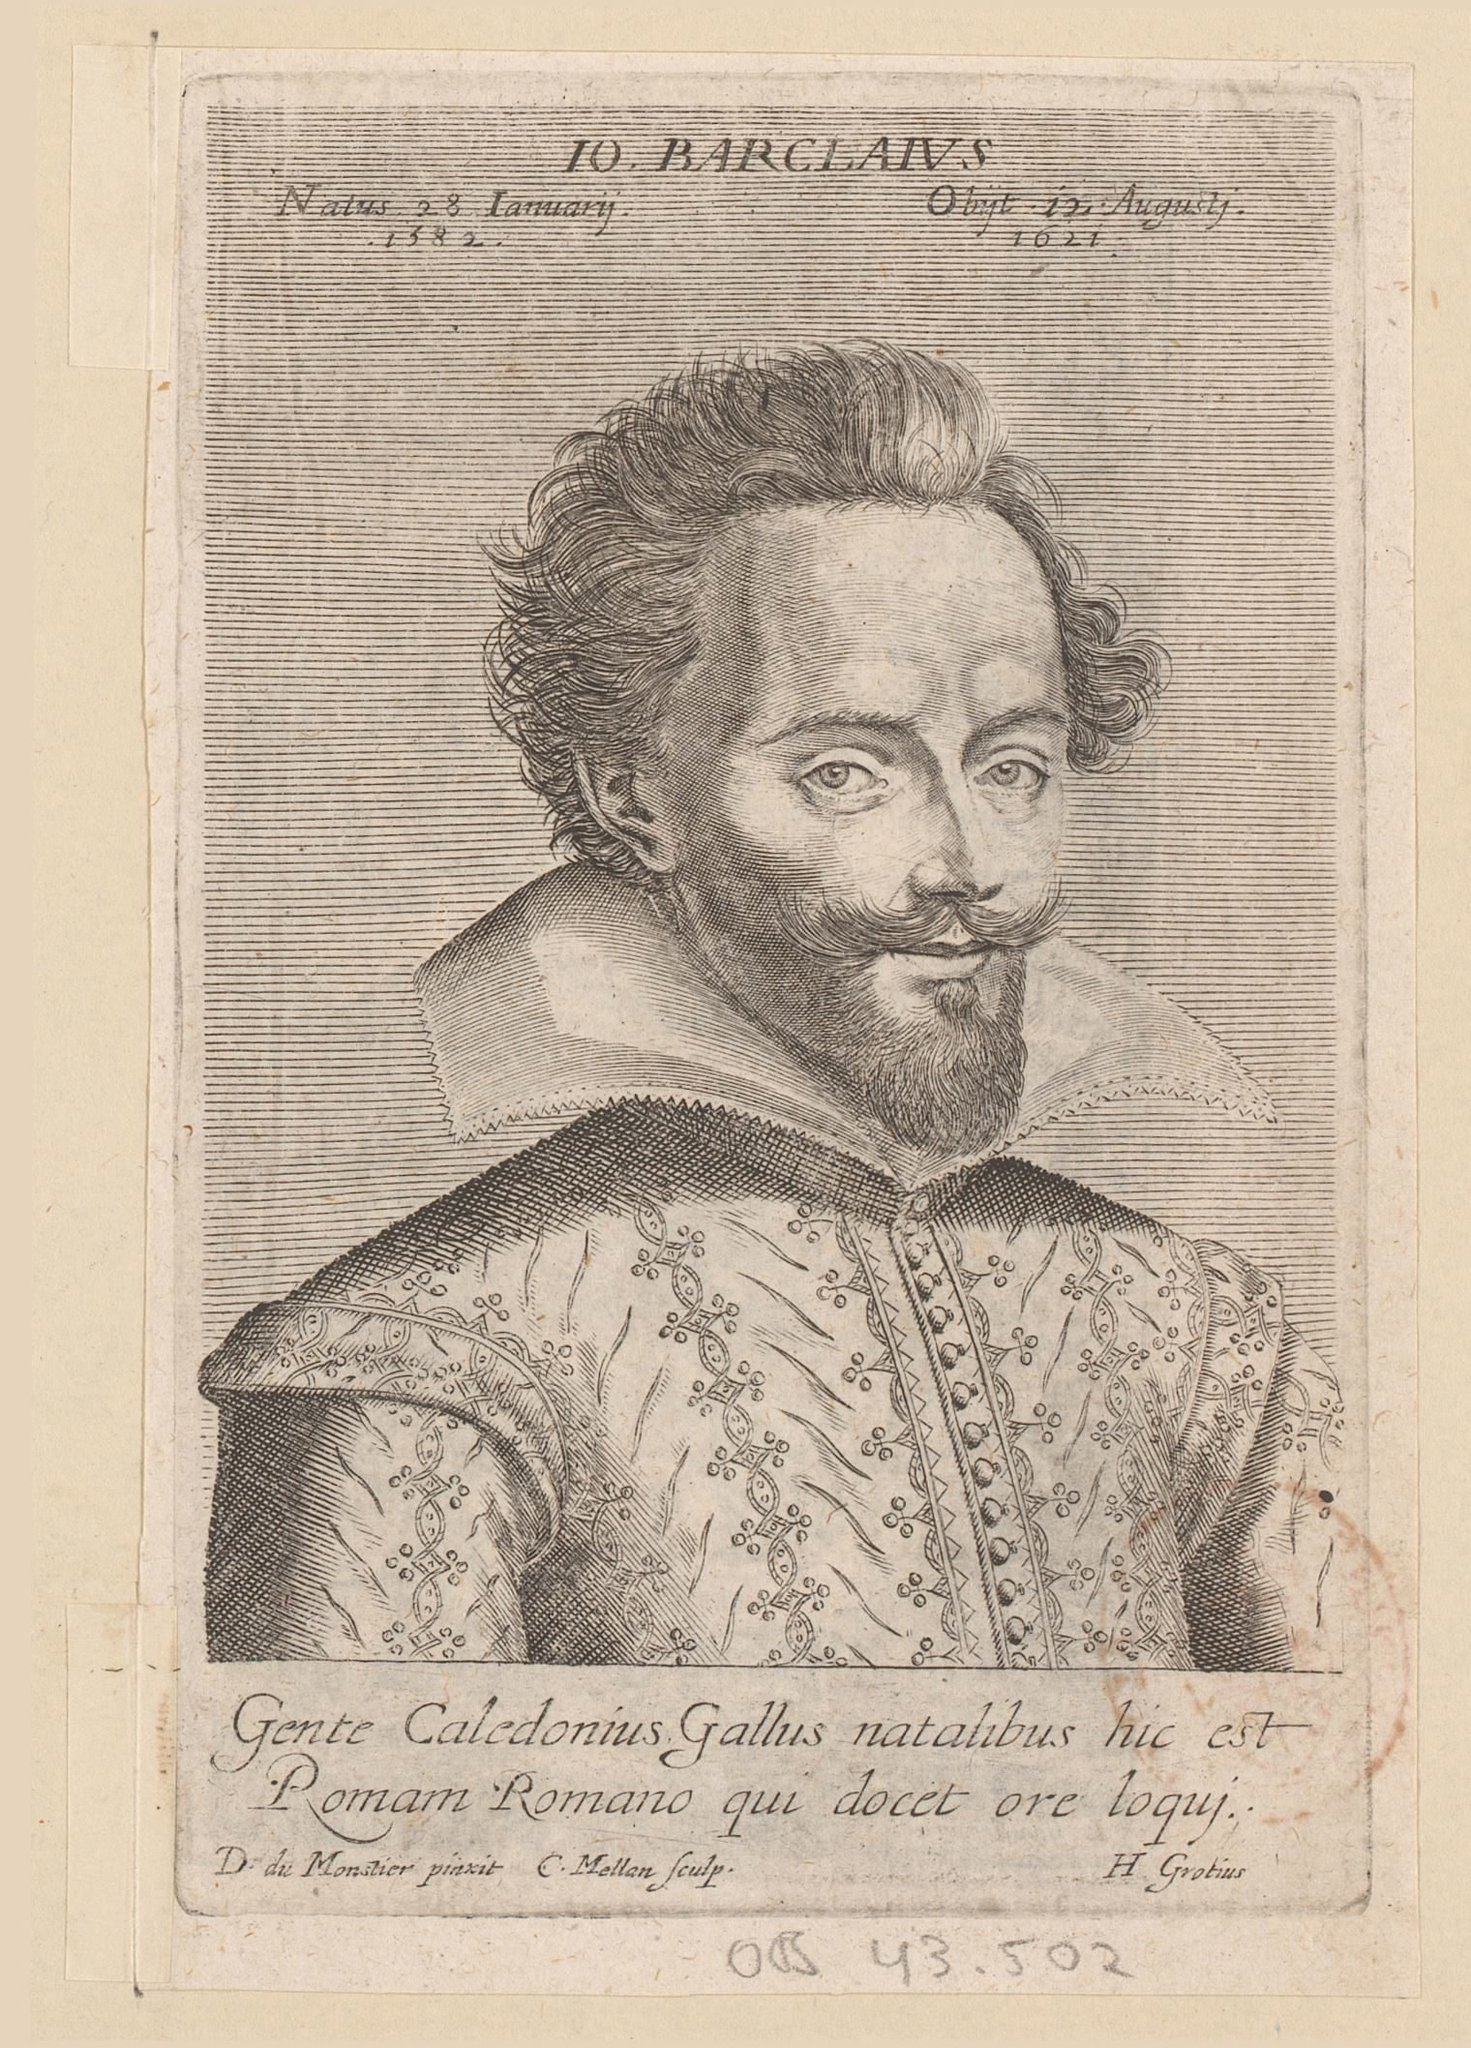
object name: print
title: Barclaius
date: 1622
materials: paper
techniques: engraving, etching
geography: france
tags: rome, historical persons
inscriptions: collector's mark: Lugt 240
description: Prent uit: Barclay, Jean. L'Argénis. Parijs: Claude Griset, 1624.